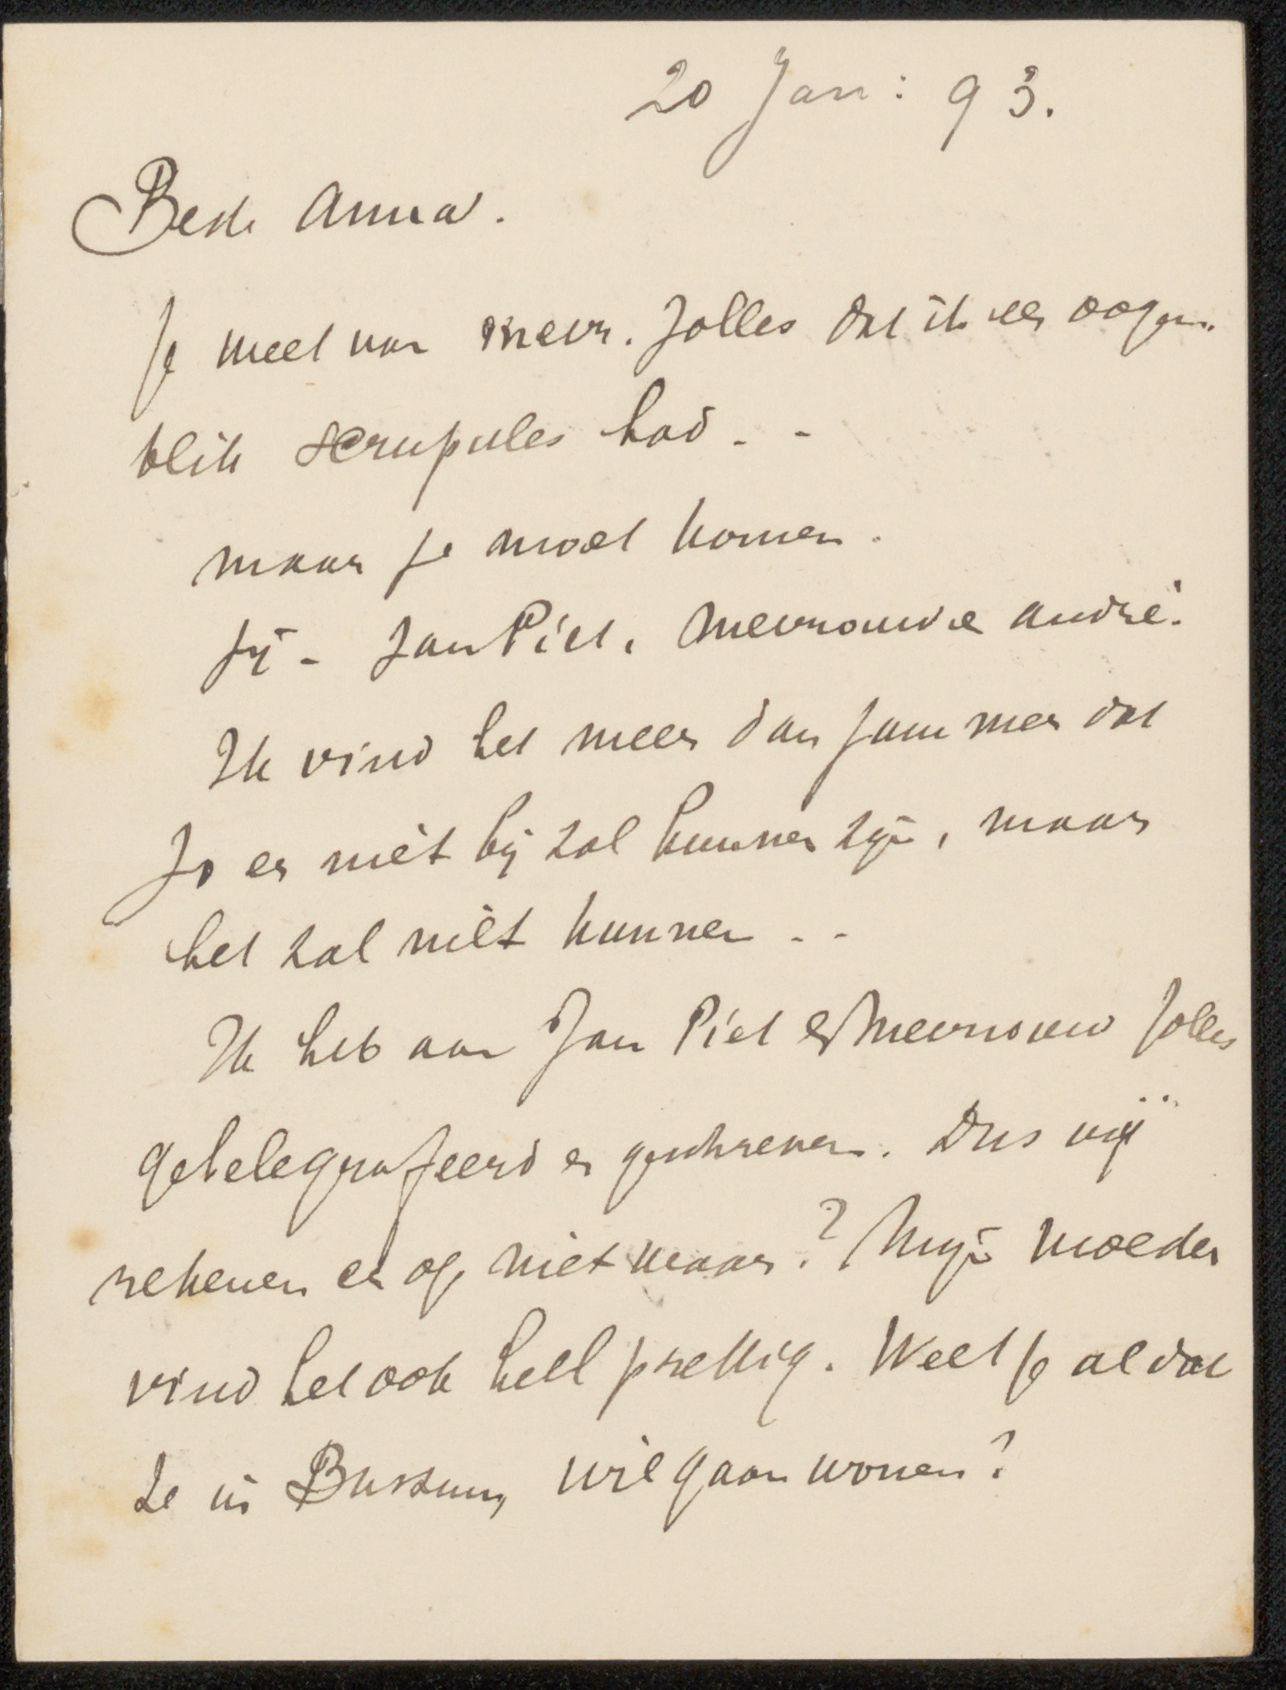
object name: letter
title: Brief aan Anna Dorothea Dirks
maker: antoon derkinderen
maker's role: draughtsman, painter, print maker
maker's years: 1859-1925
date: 1874-1925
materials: ink, paper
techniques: pen, writing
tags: dordrecht, designer, jan veth, arnhem, painter, print maker, draughtsman, anton mauve, artist, anna dorothea dirks, jacoba cornelia jolles-singels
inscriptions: watermark, collector's mark: ‘RPK’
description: Brief gedateerd 20 Jan: 93 in latere hand.